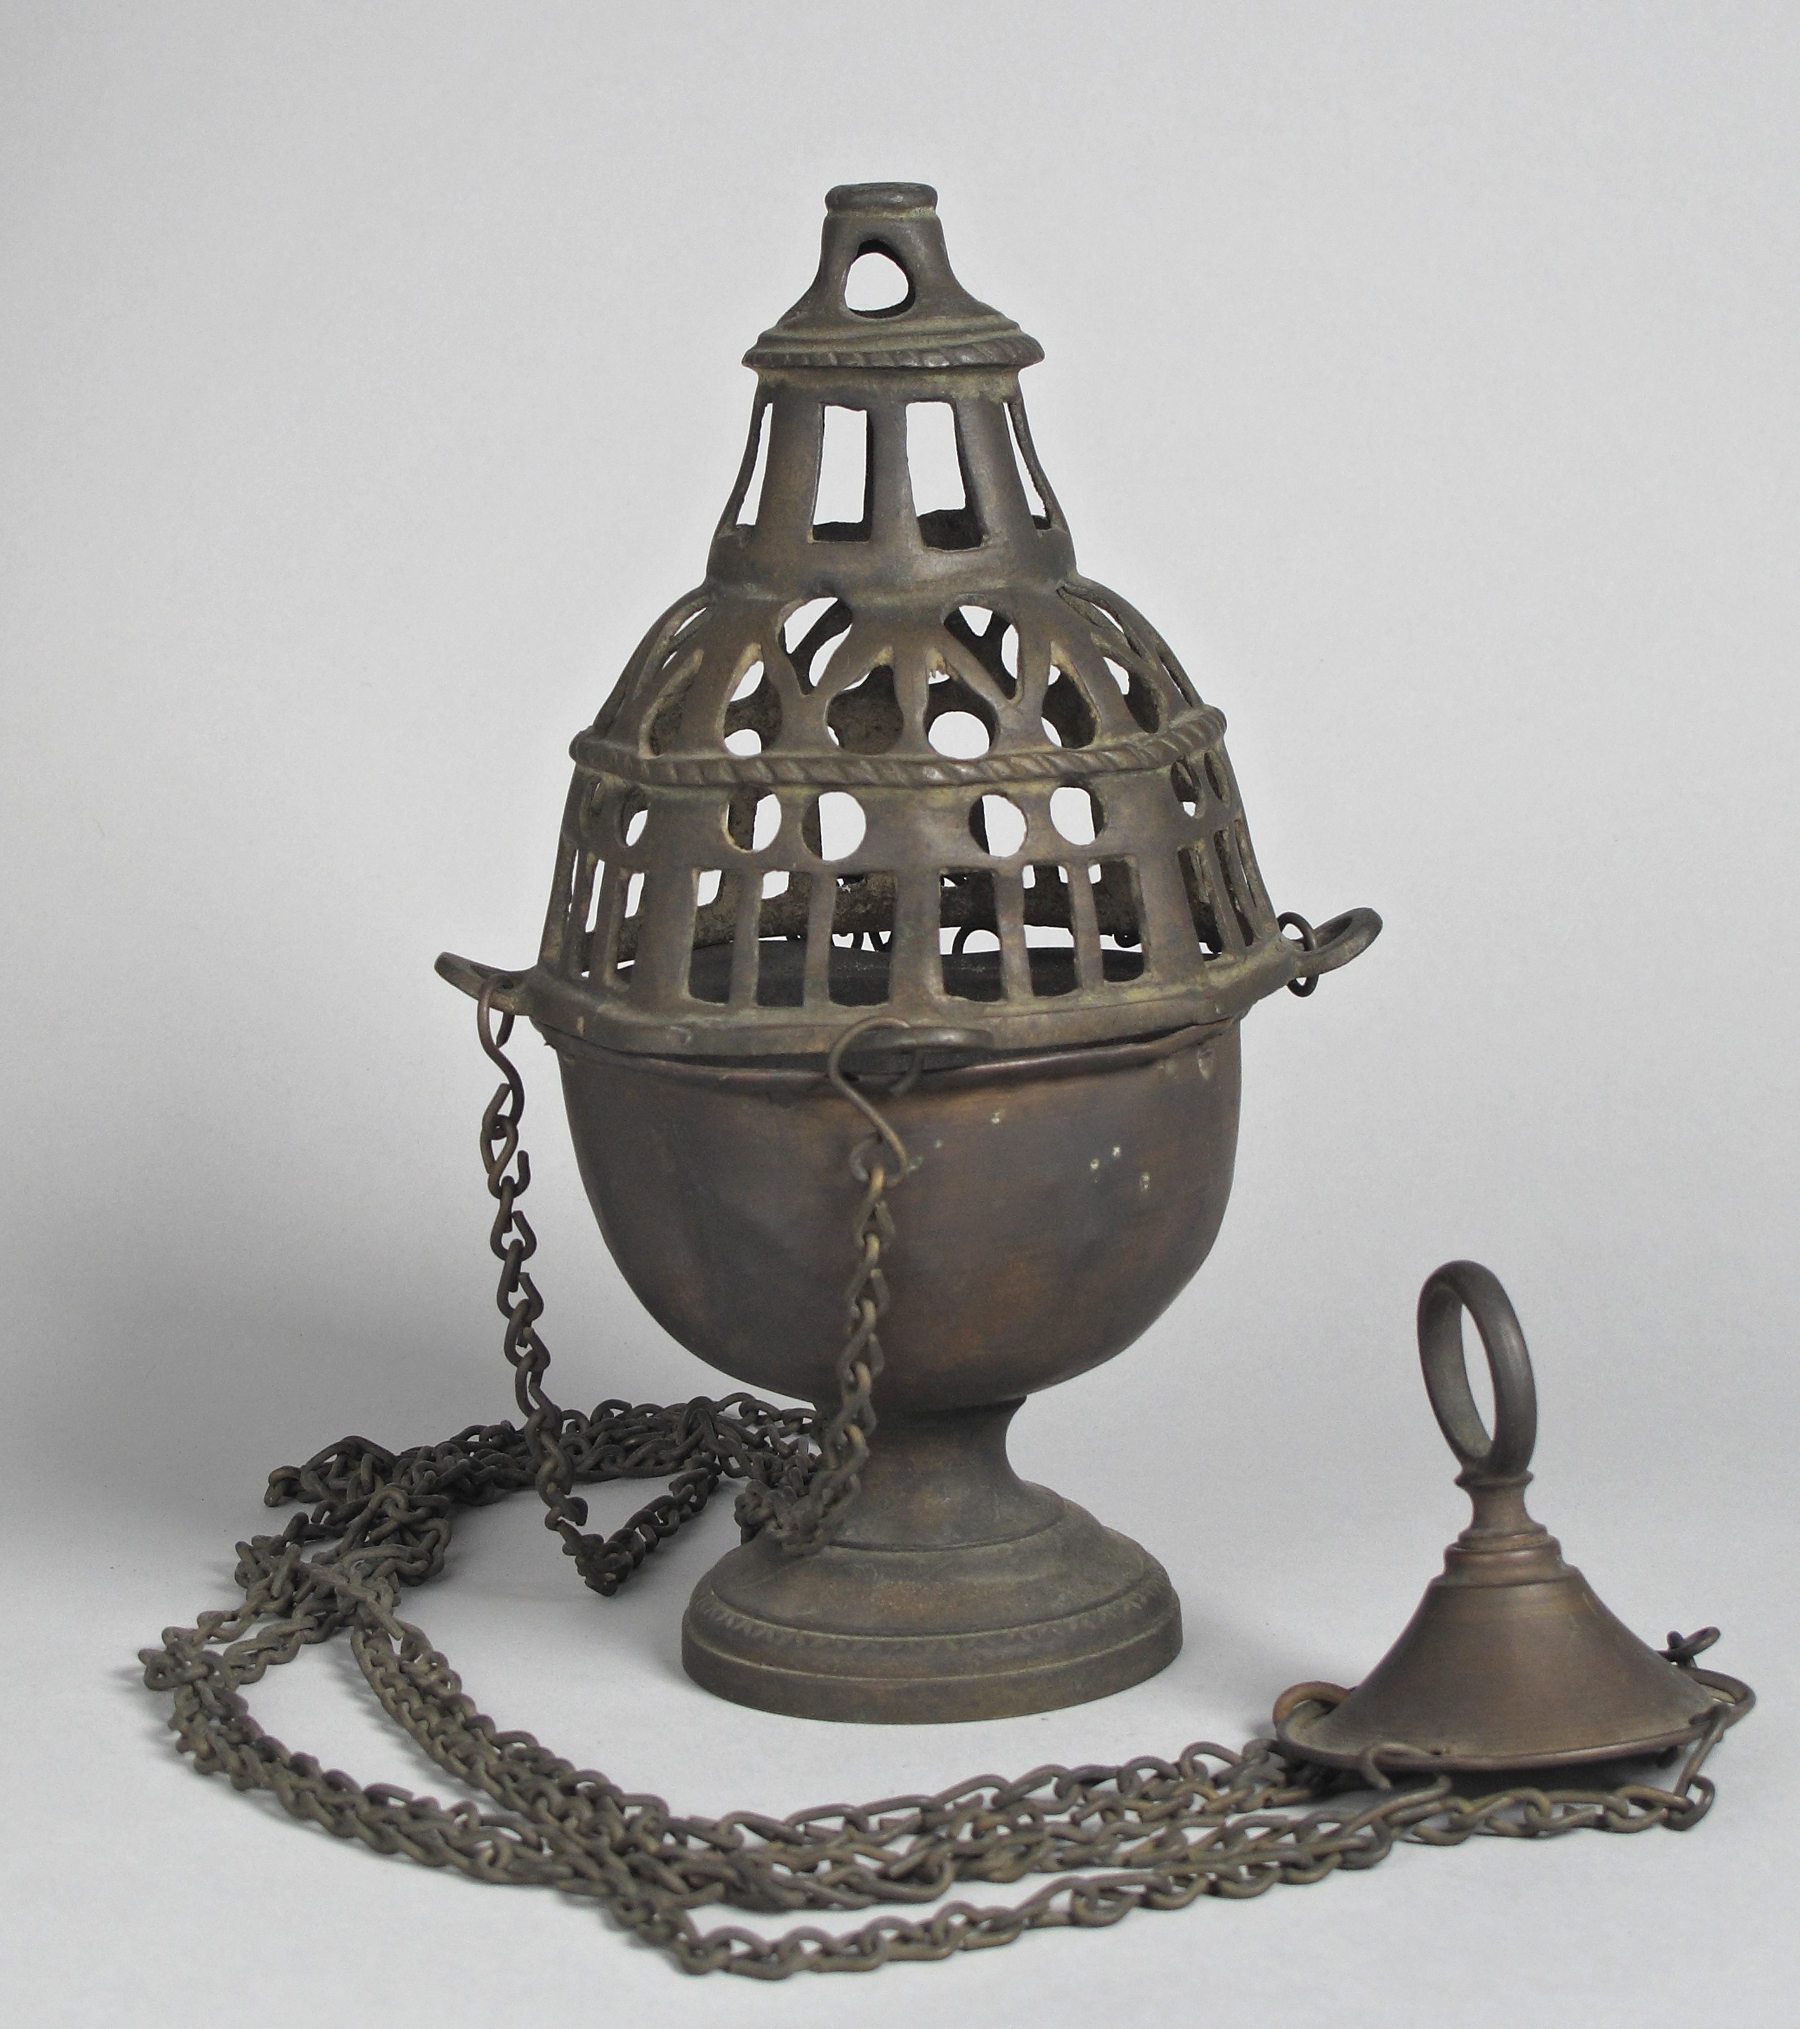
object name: censer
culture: south netherlandish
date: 1501-1600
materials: brass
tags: censers